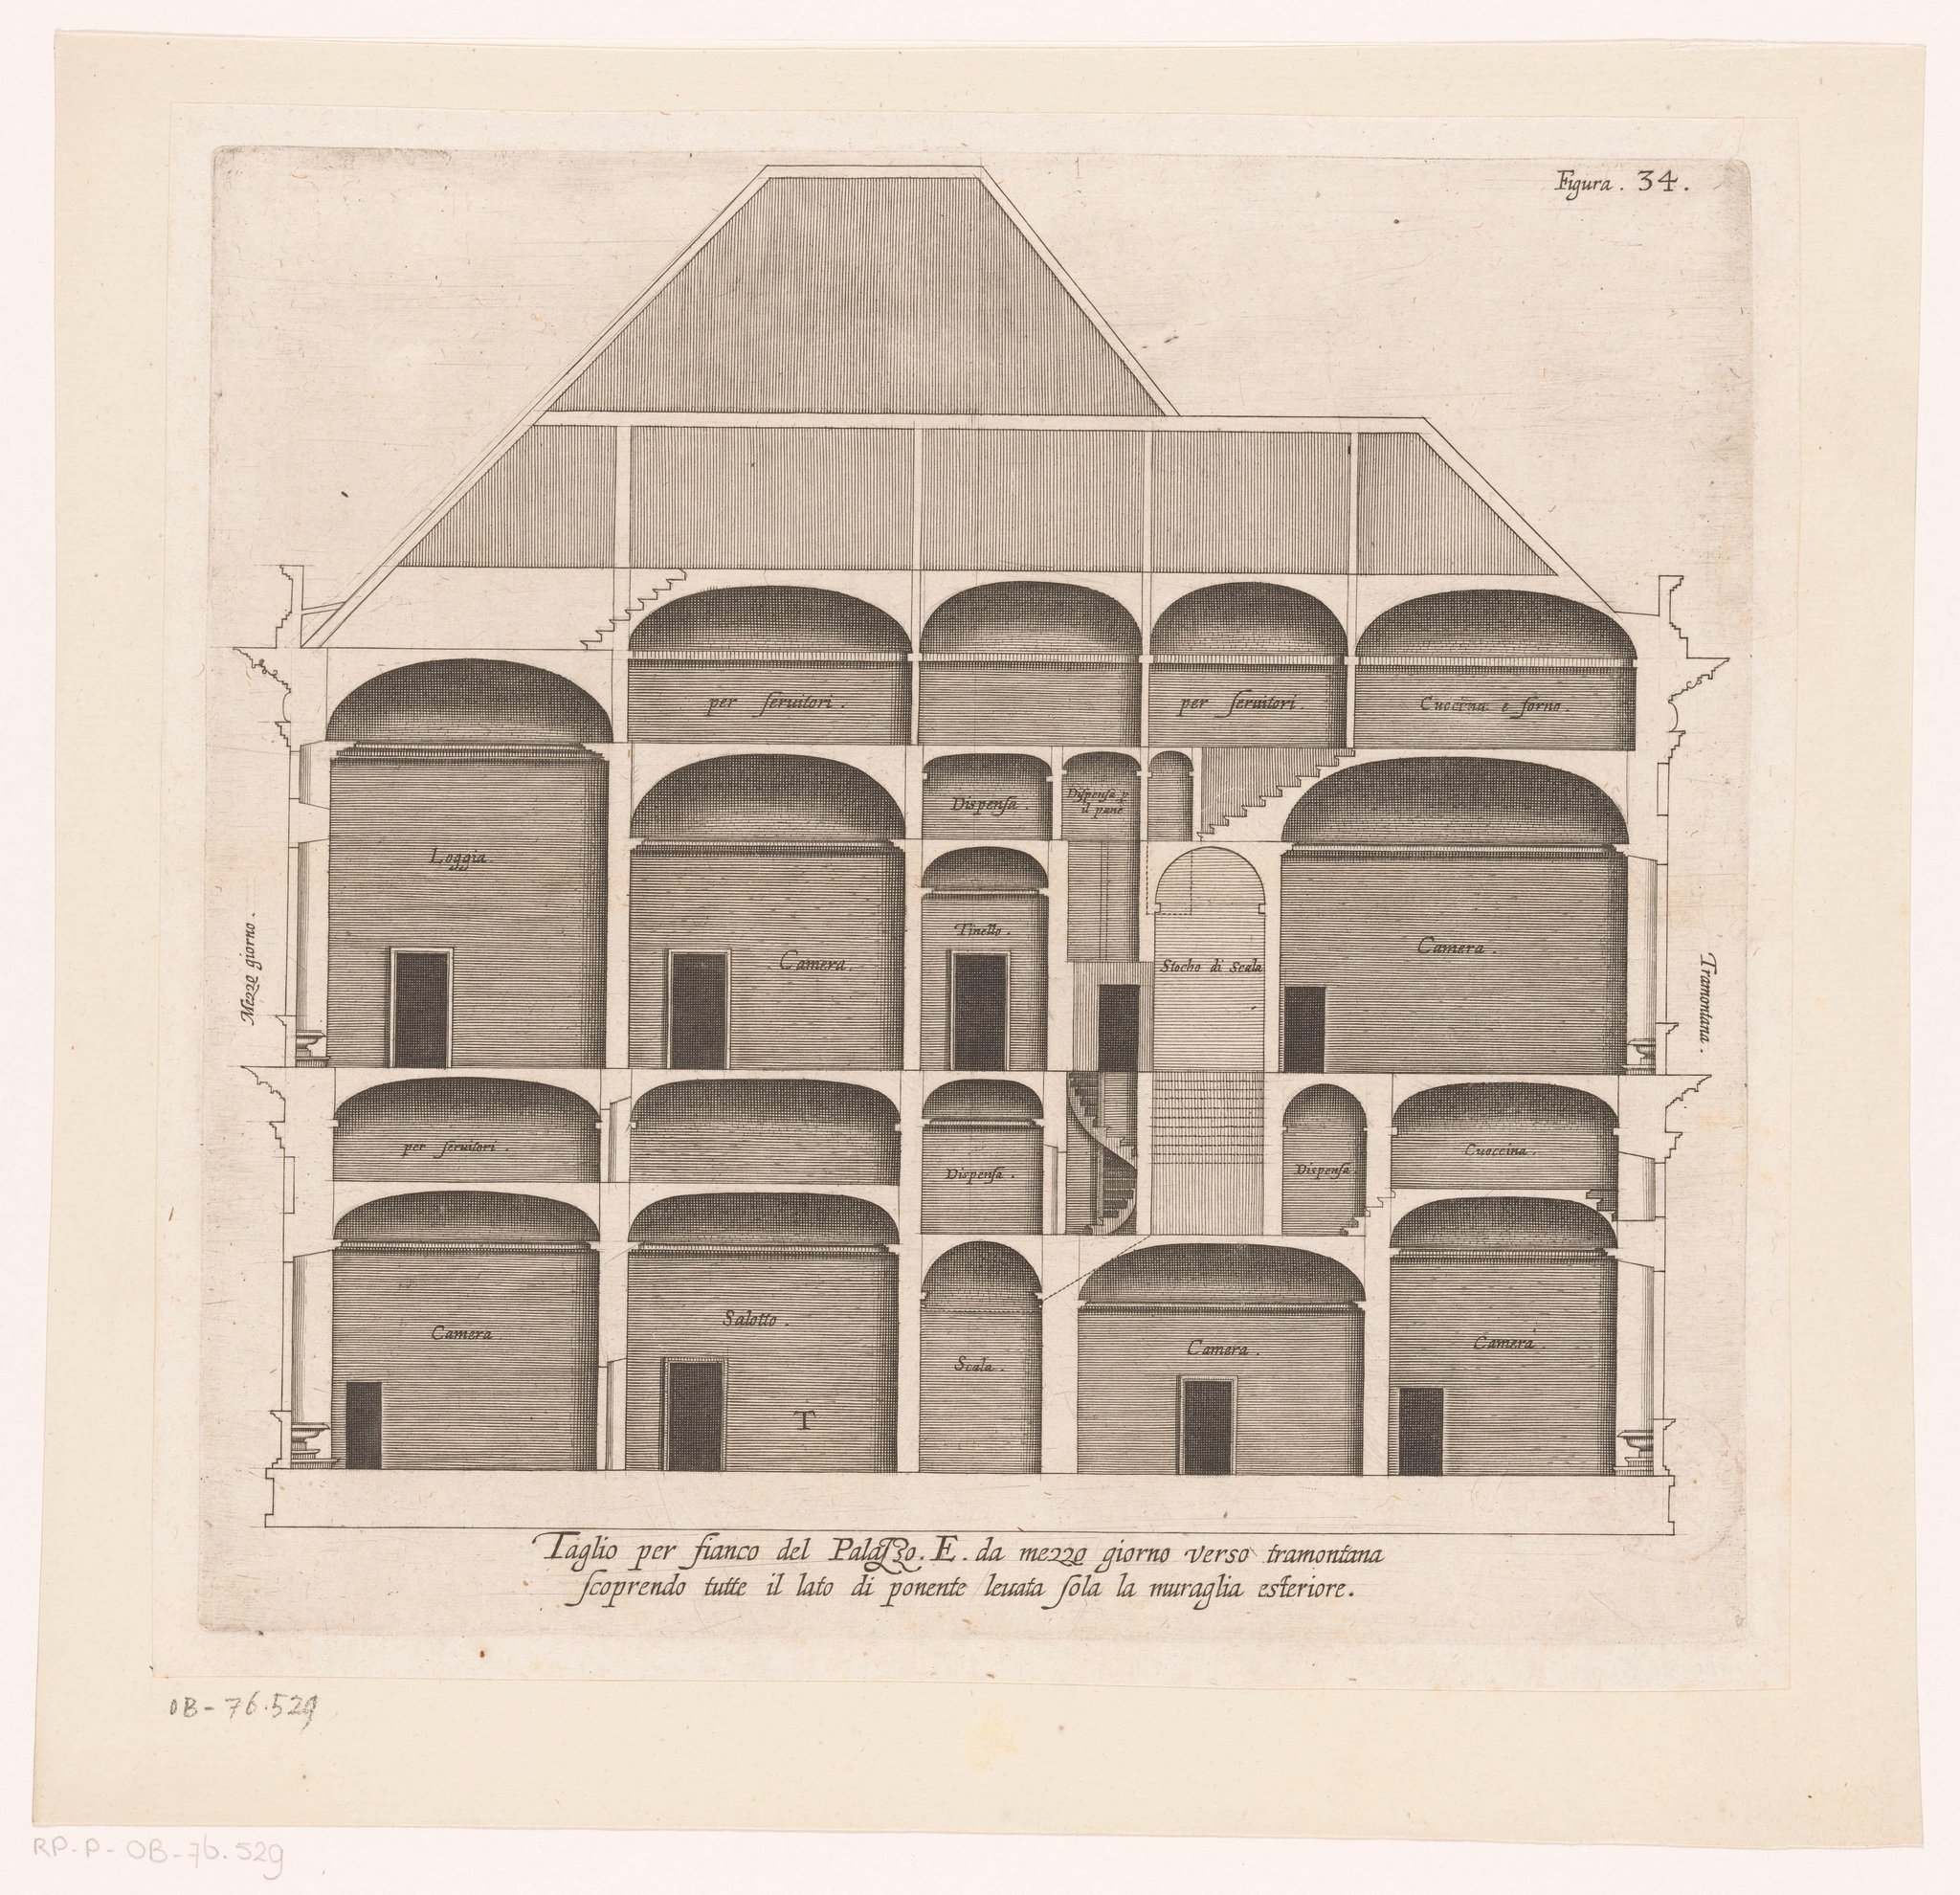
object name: ornament print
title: Langsdoorsnede van de villa Pallavicino delle Peschiere te Genua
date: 1622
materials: paper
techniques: engraving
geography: antwerp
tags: hôtel, i.e. small palace in city - aa - civic architecture: inside, section ~ architectural design or model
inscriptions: collector's mark: Lugt 240